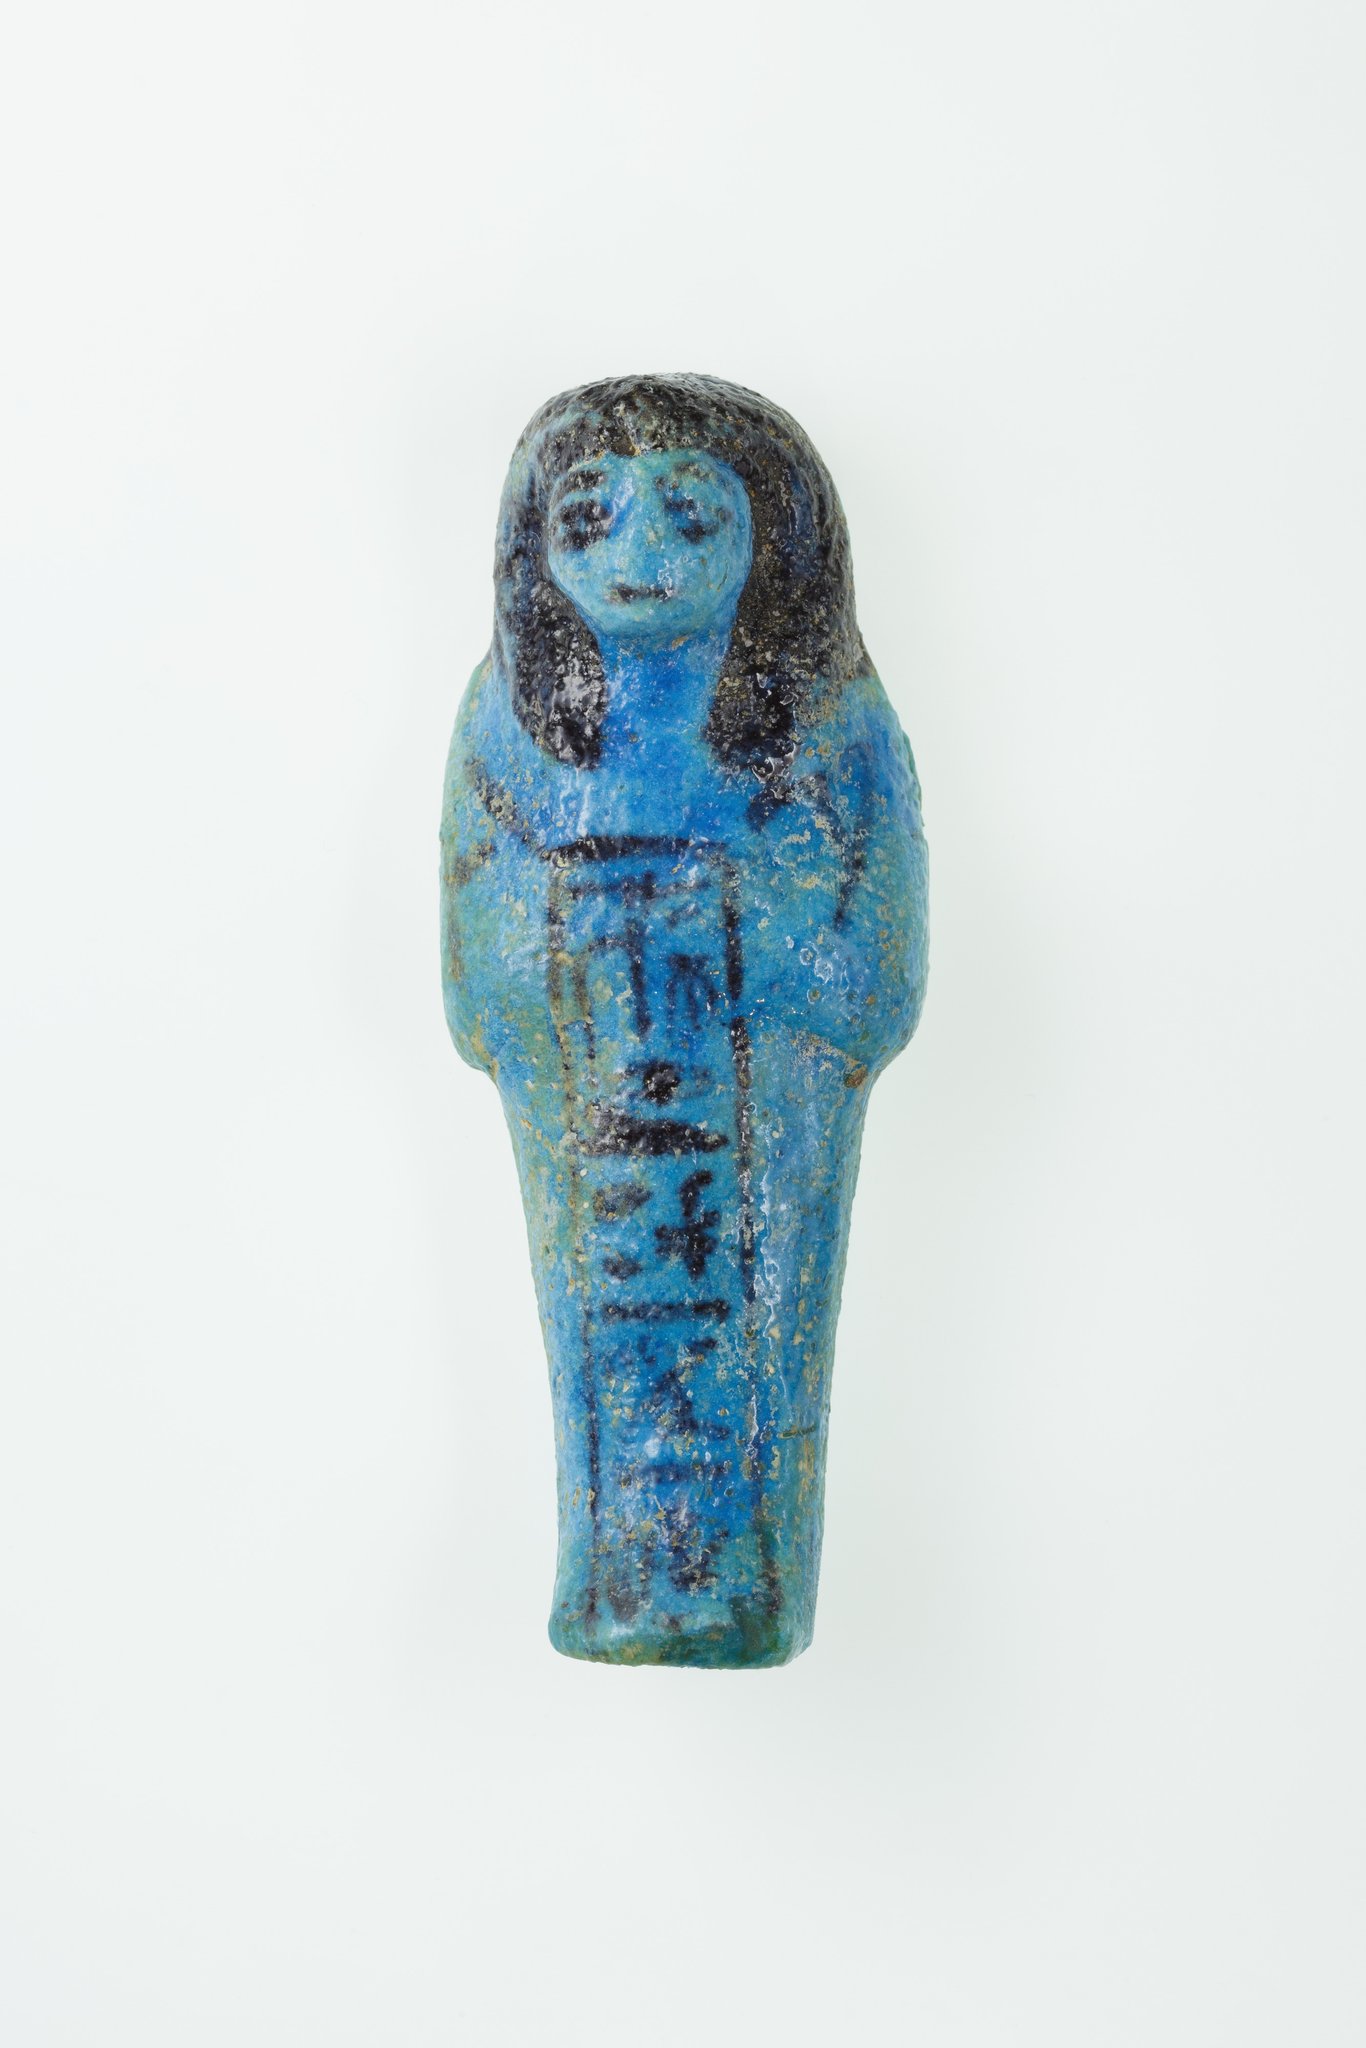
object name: shabti, worker, nauny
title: Worker Shabti of Nauny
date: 1050 BCE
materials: faience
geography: egypt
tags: hieroglyphs